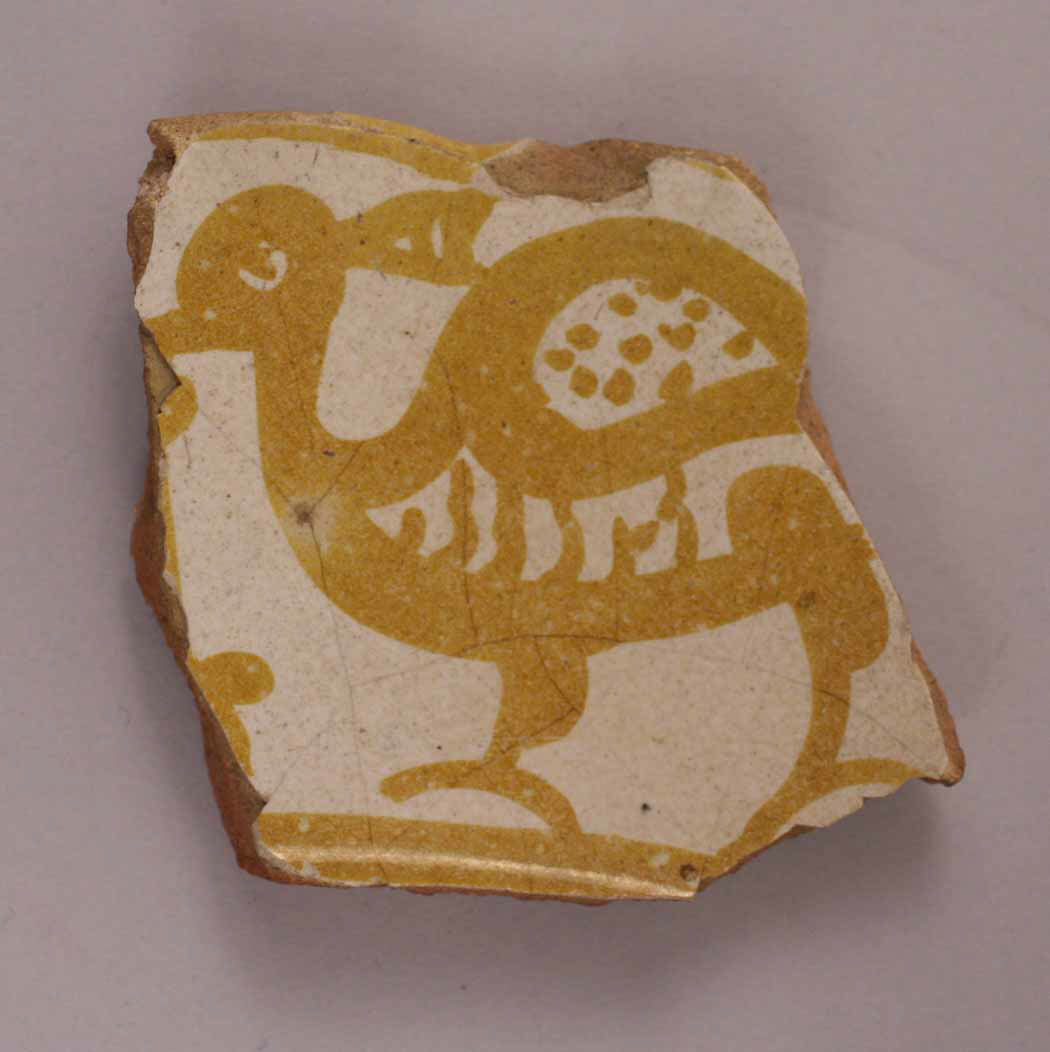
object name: fragment of a bowl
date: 901-1200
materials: glaze, stonepaste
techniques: painting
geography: egypt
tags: birds